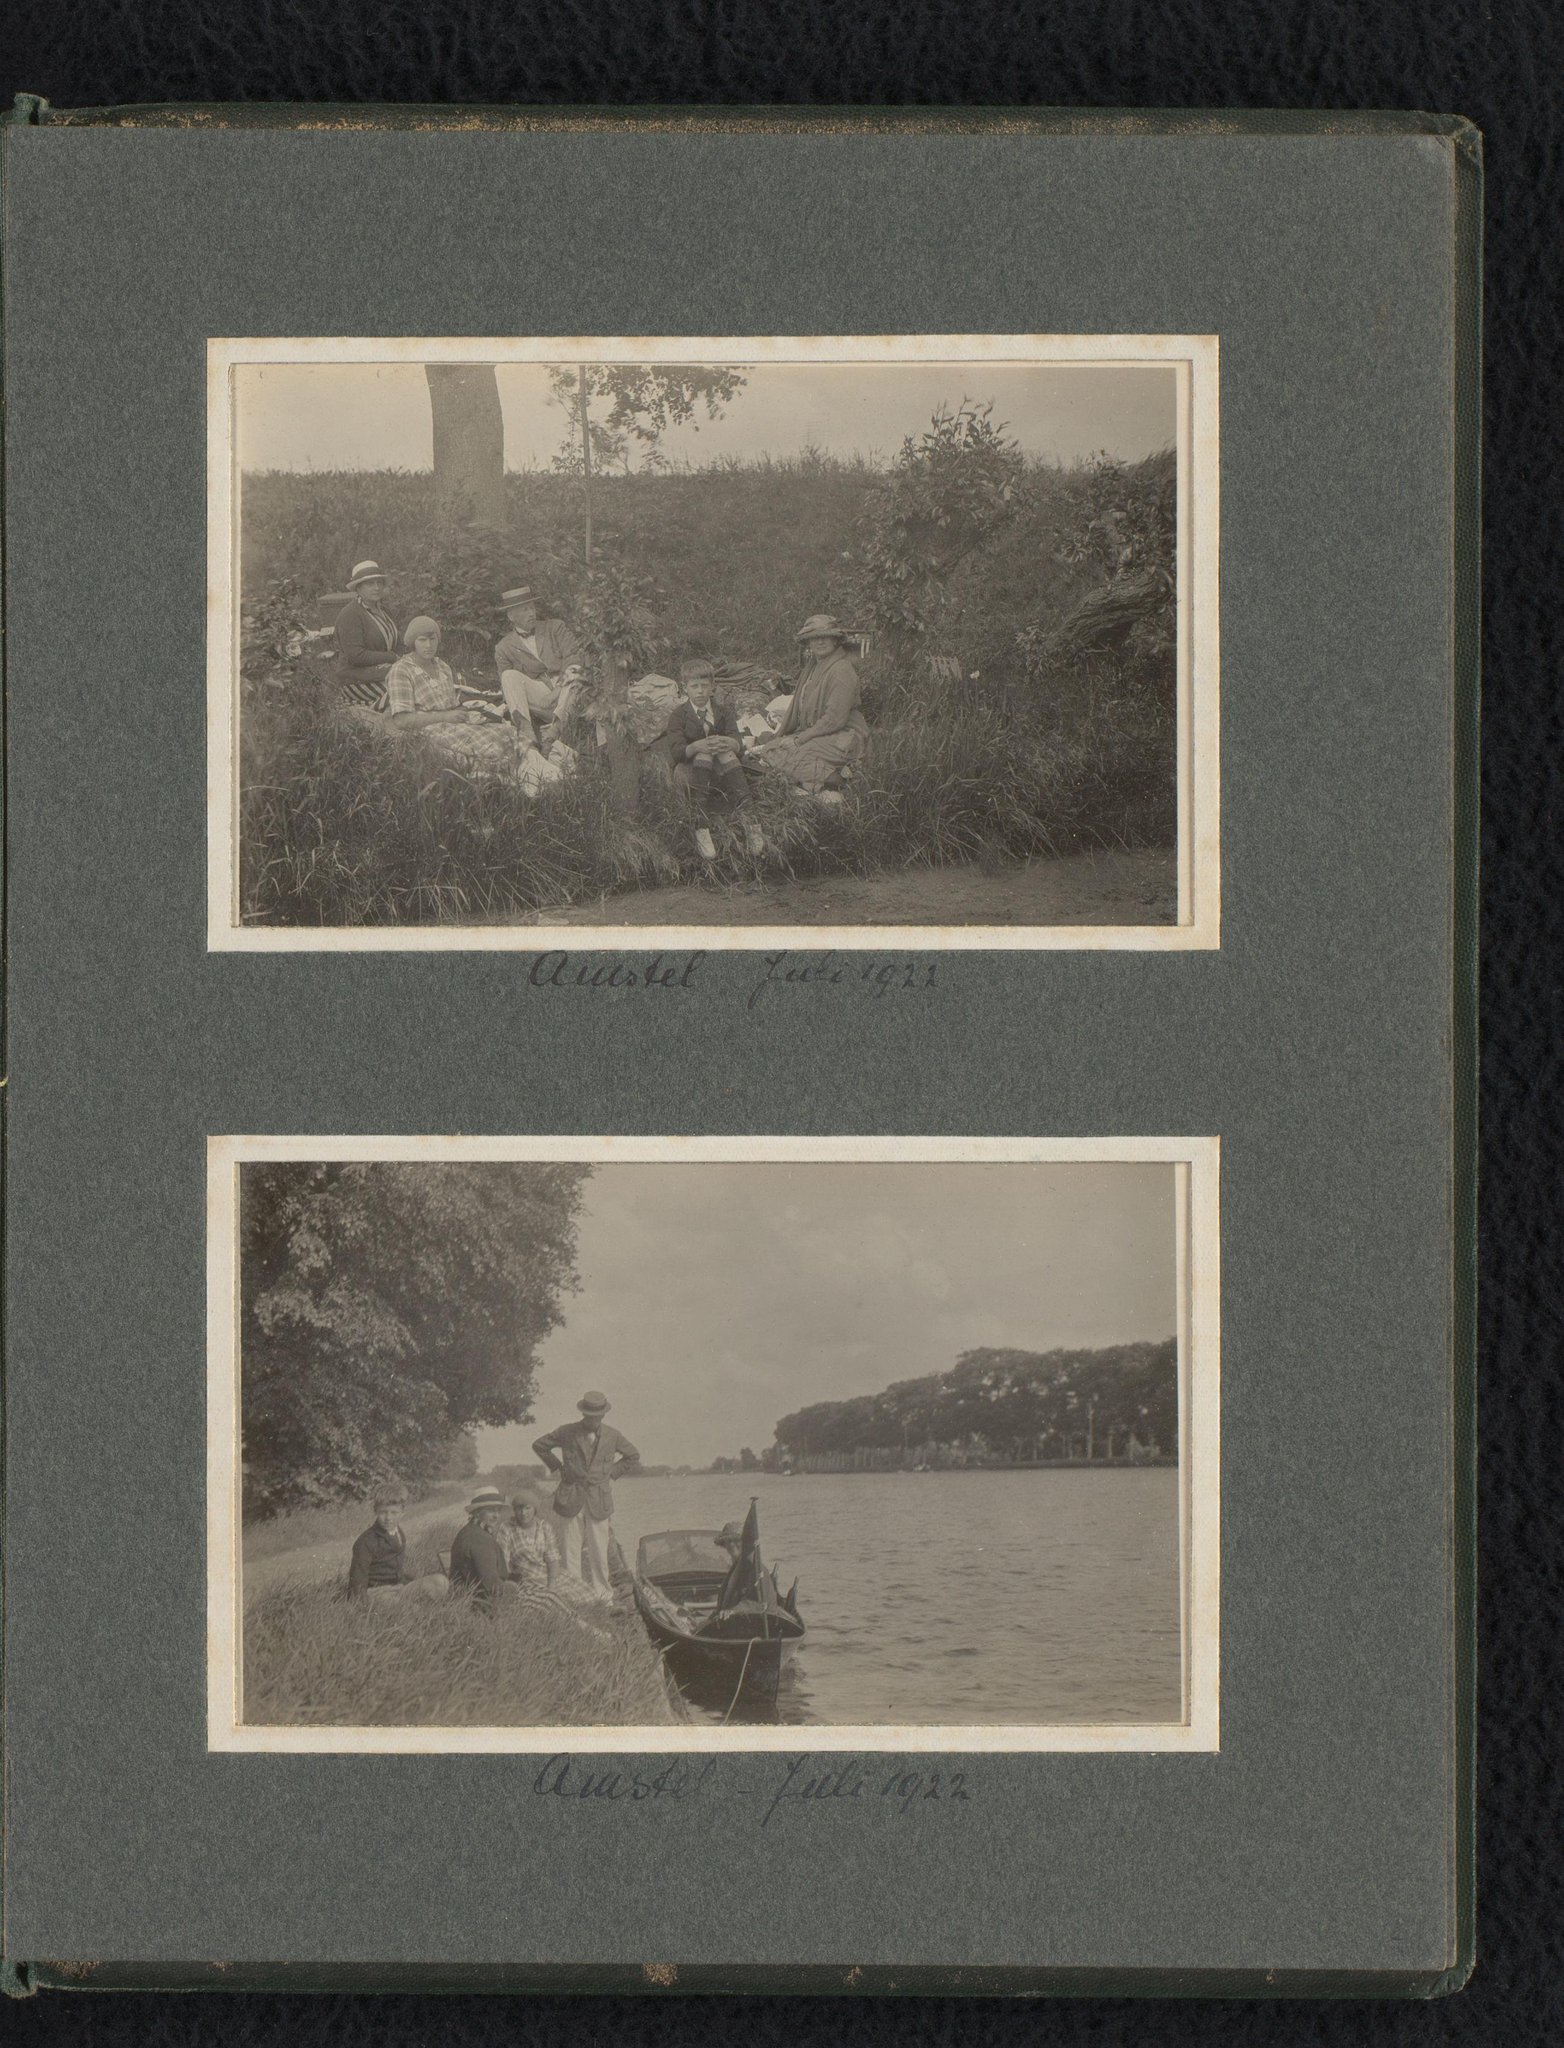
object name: album leaf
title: Twee foto's van Caroline, Cay en Frank en andere familieleden tijdens een vaartocht over de Amstel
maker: hendrik herman van den berg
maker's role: amateurfotograaf, jurist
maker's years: 1875-1944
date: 1907-1922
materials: paper, cardboard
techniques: gelatin silver print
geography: north holland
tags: the hague, caroline louise van den berg-van den berg, amsterdam, carel frederik van den berg (cay), frank willem van den berg (1912-1998), river, historical persons, picnic, alfresco, 'déjeuner sur l'herbe'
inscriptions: caption: ‘Amstel Juli 1922/ Amstel Juli 1922’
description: Deze foto's maken deel uit van een album.